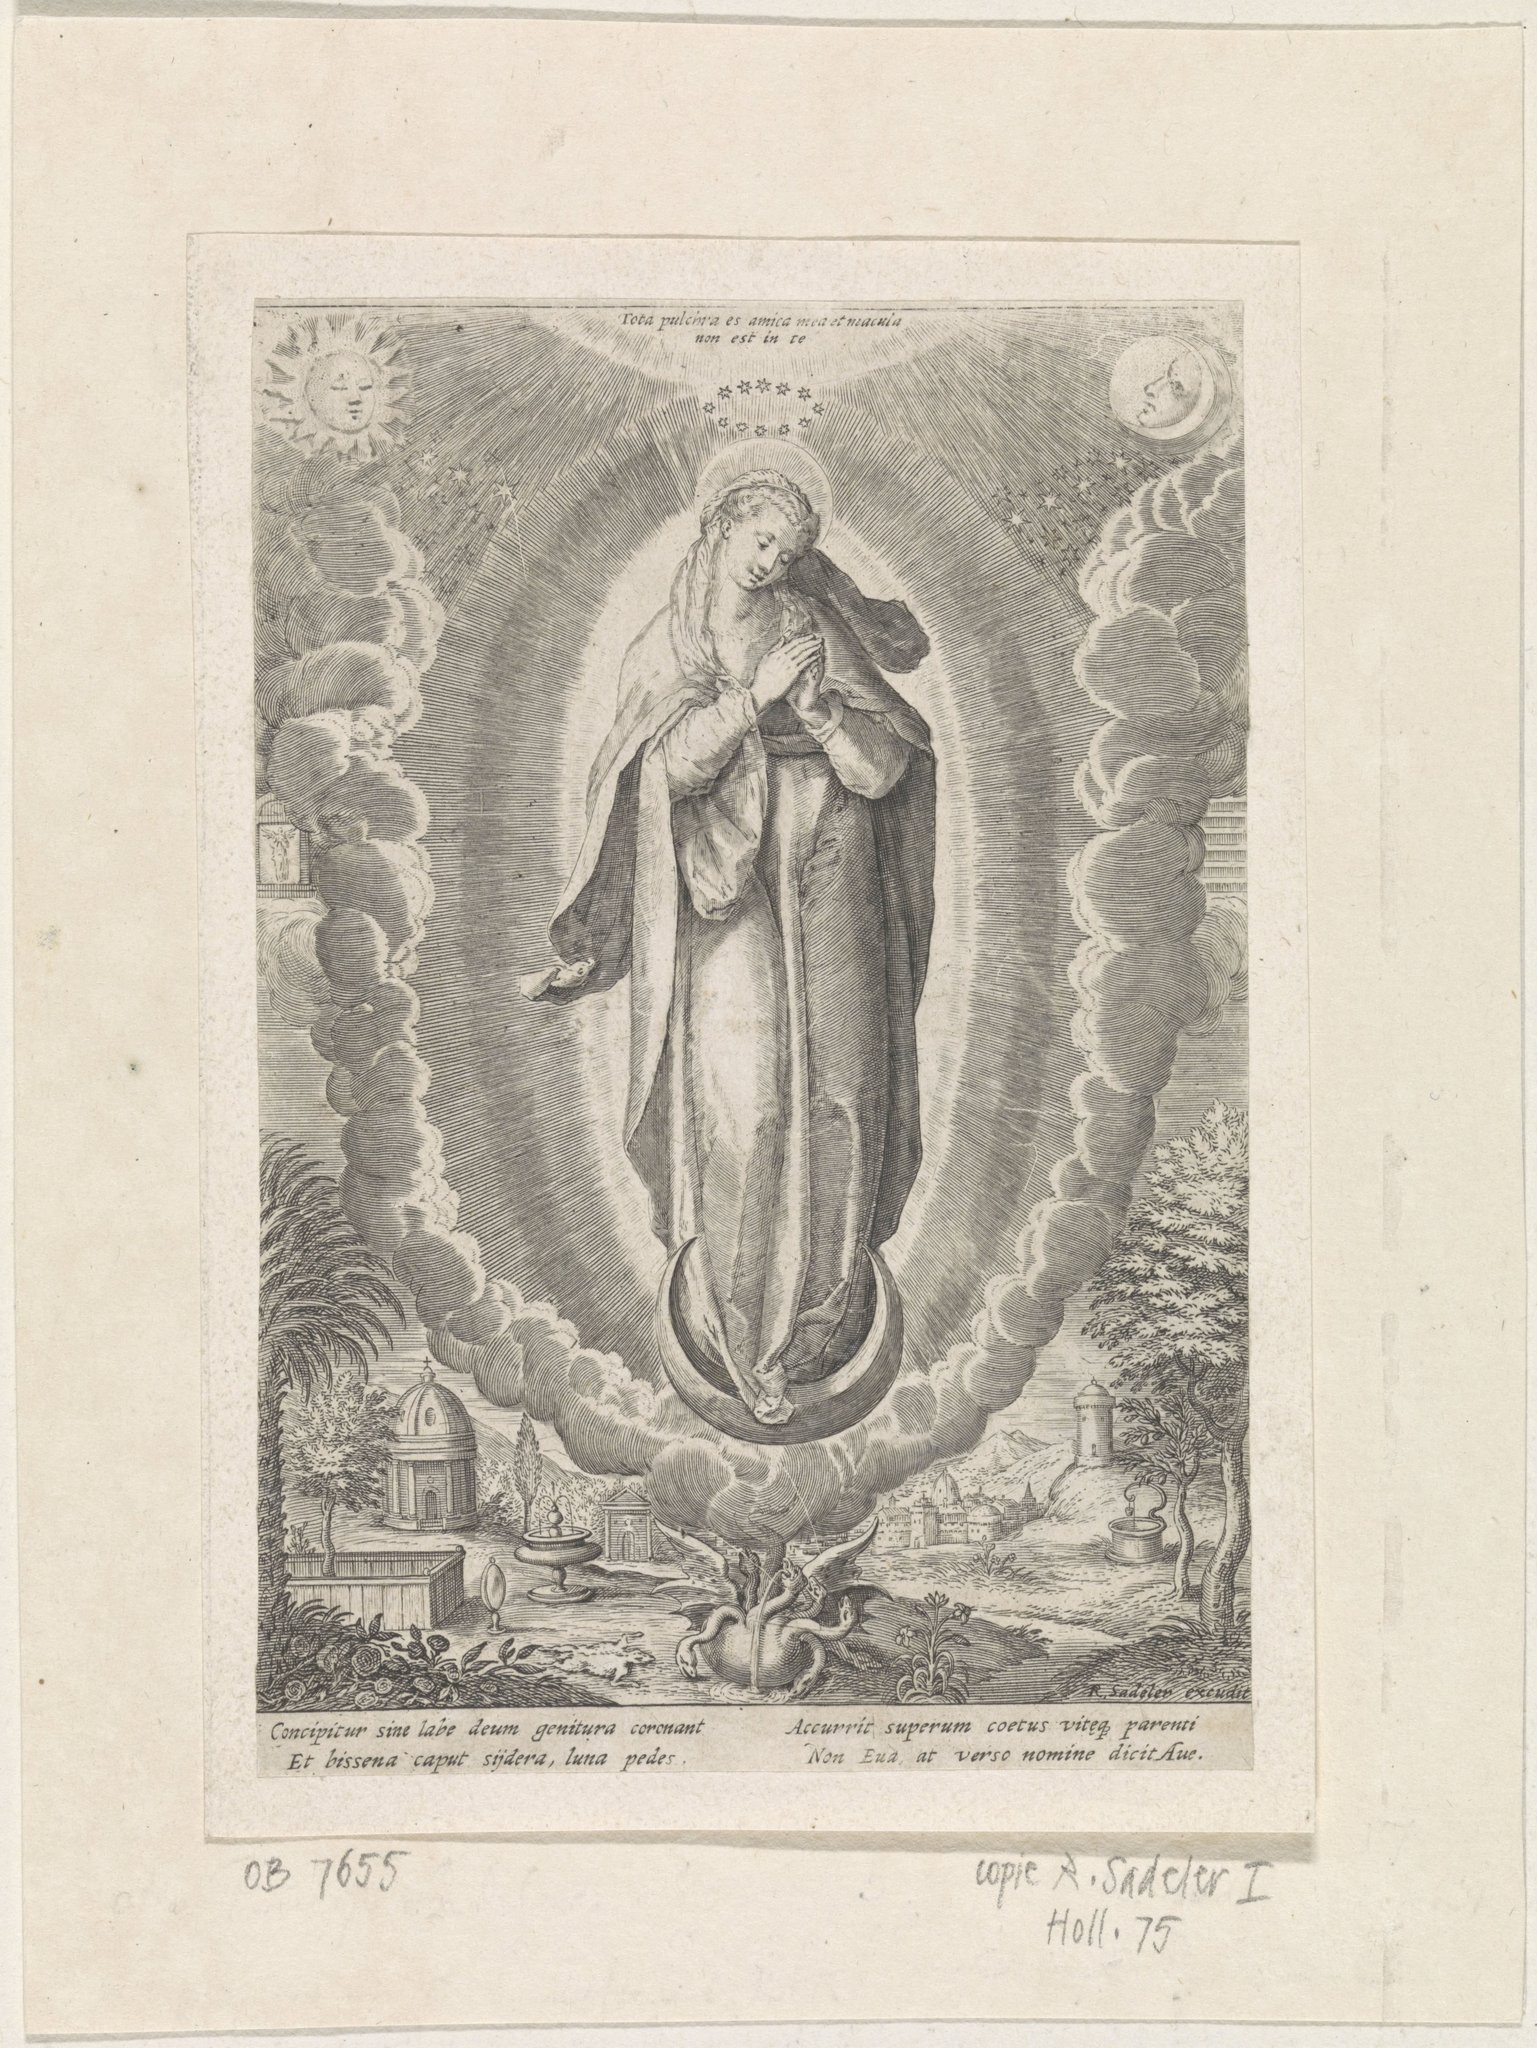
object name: print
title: Maria op de maansikkel in mandorla met rondom haar de symbolen van de Maria-litanie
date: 1605-1632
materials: paper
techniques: engraving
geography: munich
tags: mary or madonna with symbols of the lauretanian litany, mandorla, madonna on the crescent of the moon (sometimes called queen of heaven) (in mandorla), dragon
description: In de lucht de maagd Maria staande op de maansikkel in een mandorla. Ze draagt een kroon met sterren. Links en rechts in de bovenhoek de zon en de maan. Op de aarde een landschap met zestien symbolen van de Maria-litanie.